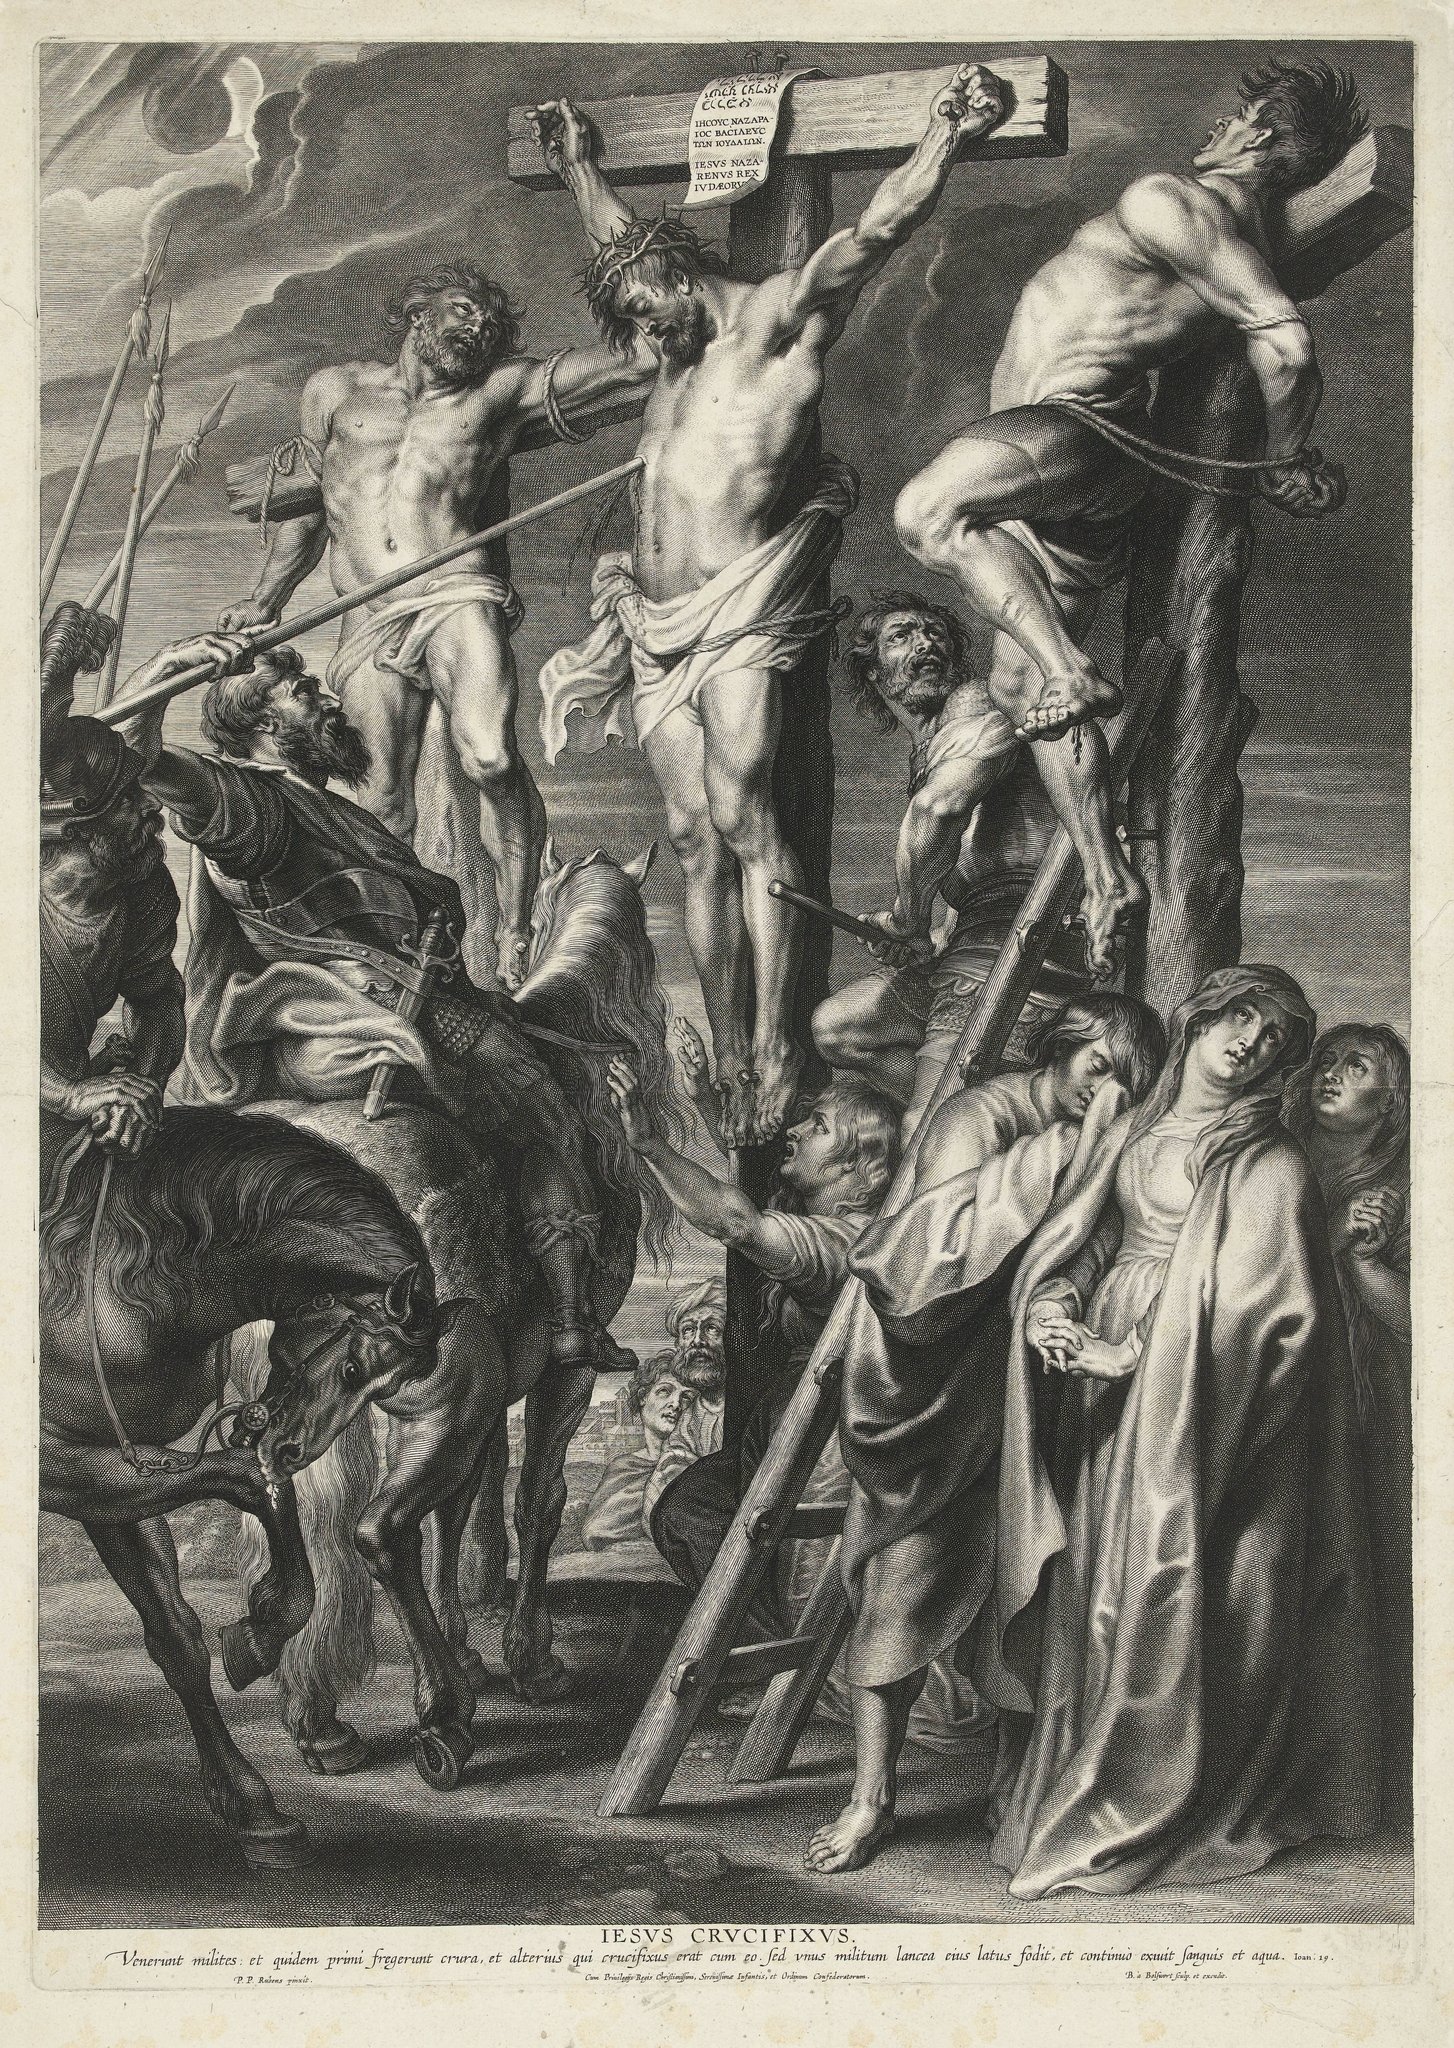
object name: print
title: Iesvs crvcifixvs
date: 1631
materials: paper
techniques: engraving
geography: netherlands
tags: longinus pierces christ's side with a lance, the crucifixion of christ: christ's death on the cross; golgotha (matthew 27:45-58; mark 15:33-45; luke 23:44-52; john 19:25-38)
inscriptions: collector's mark: Lugt 240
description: Kruisiging van Christus met de soldaat Longinus die zijn speer in Christus' zij steekt. Maria en Johannes staan treurend onder het kruis, Maria Magdalena knielt bij de met nagels doorboorde voeten van Christus. Aan weerszijden van Christus hangen de twee misdadigers aan kruizen. In de marge onder staat een Latijnse bijbeltekst uit Johannes 19.